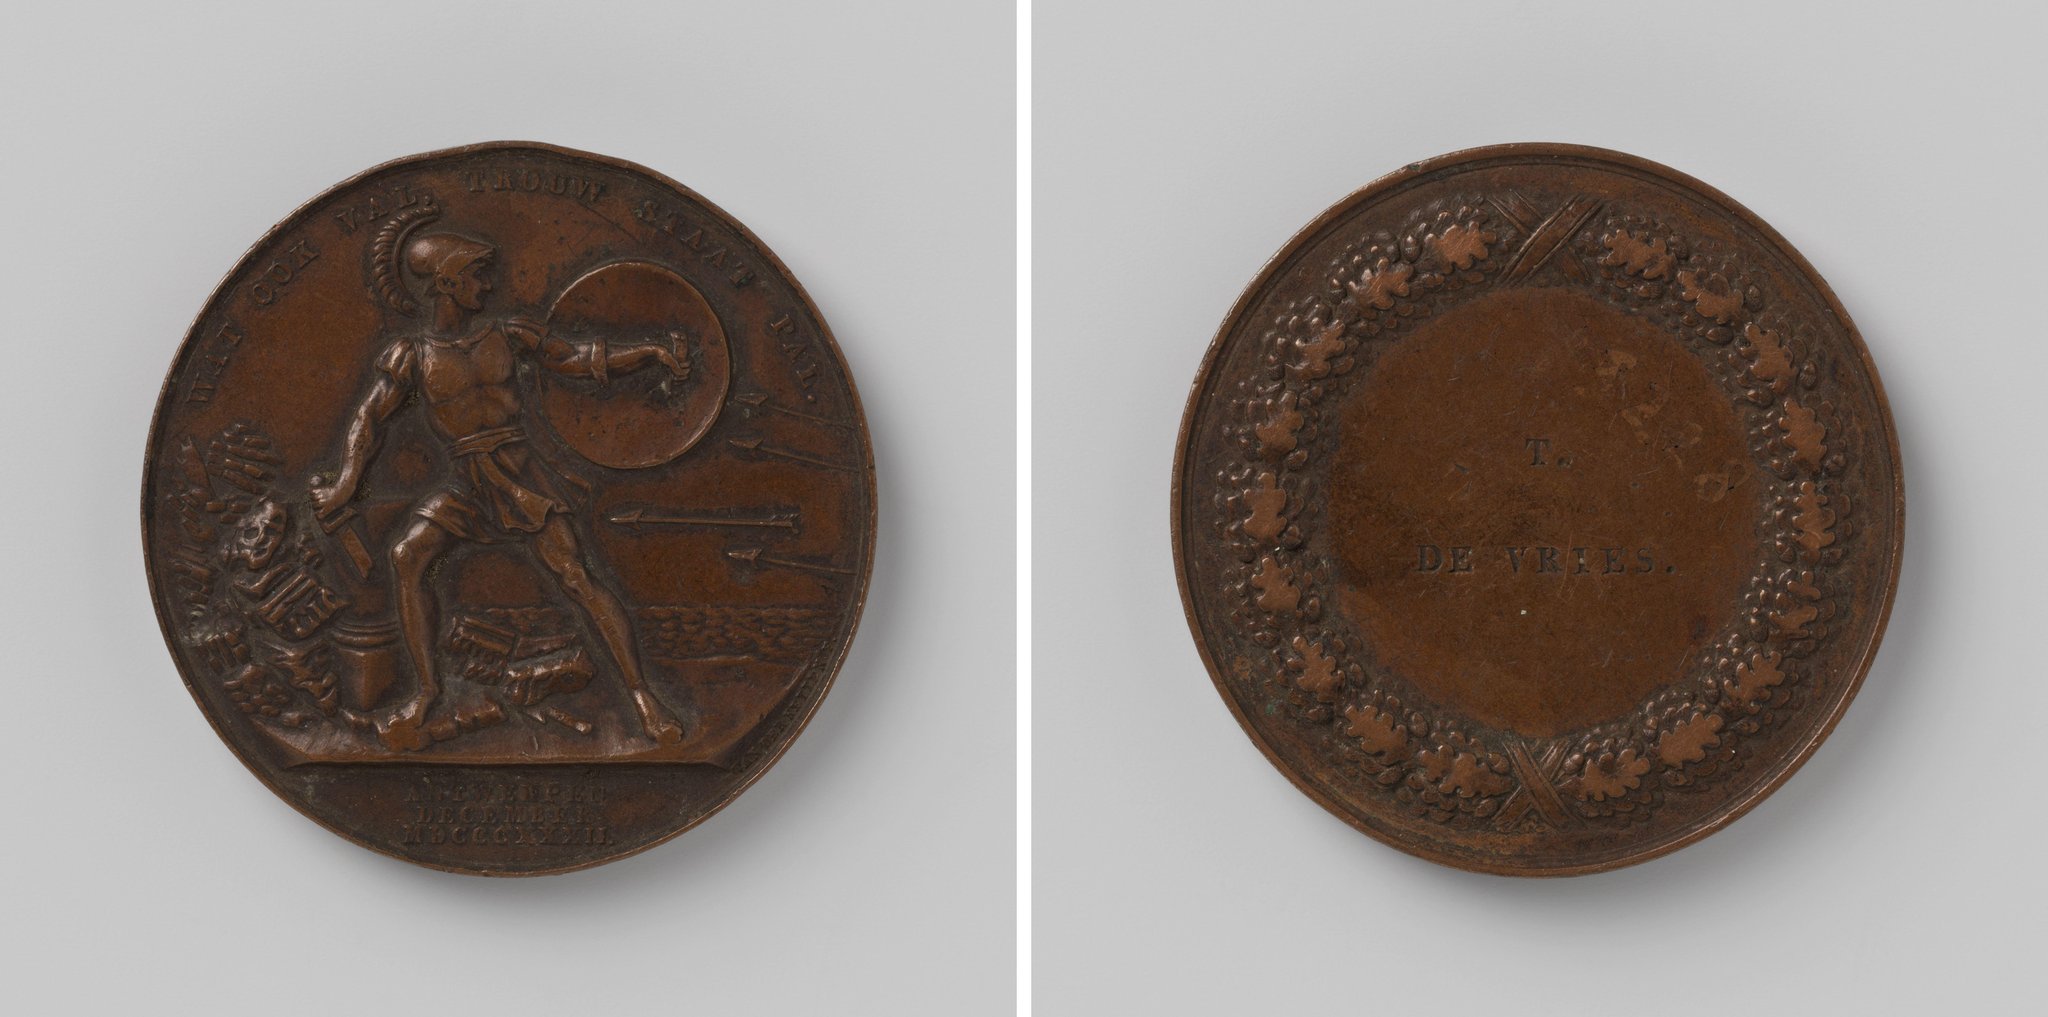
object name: honorary medal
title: Verdediging van de citadel van Antwerpen, penning door de Commissie van erkentenis te Amsterdam uitgereikt aan T. de Vries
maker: david van der kellen (1804-1879)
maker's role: die cutter, draughtsman, print maker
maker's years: 1804-1879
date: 1832-1833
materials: bronze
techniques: engraving, striking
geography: utrecht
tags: t. de vries, citadel van antwerpen (19e eeuw), schelde, strijd om de citadel van antwerpen (1832), belgische revolutie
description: Bronzen penning. Voorzijde: gehelmde soldaat in Romeinse kledij staat aan Schelde voor ruine van citadel en weert met schild op hem afgeschoten pijlen af binnen omschrift; afsnede:opschrift. Keerzijde: opschrift binnen eikenkrans.